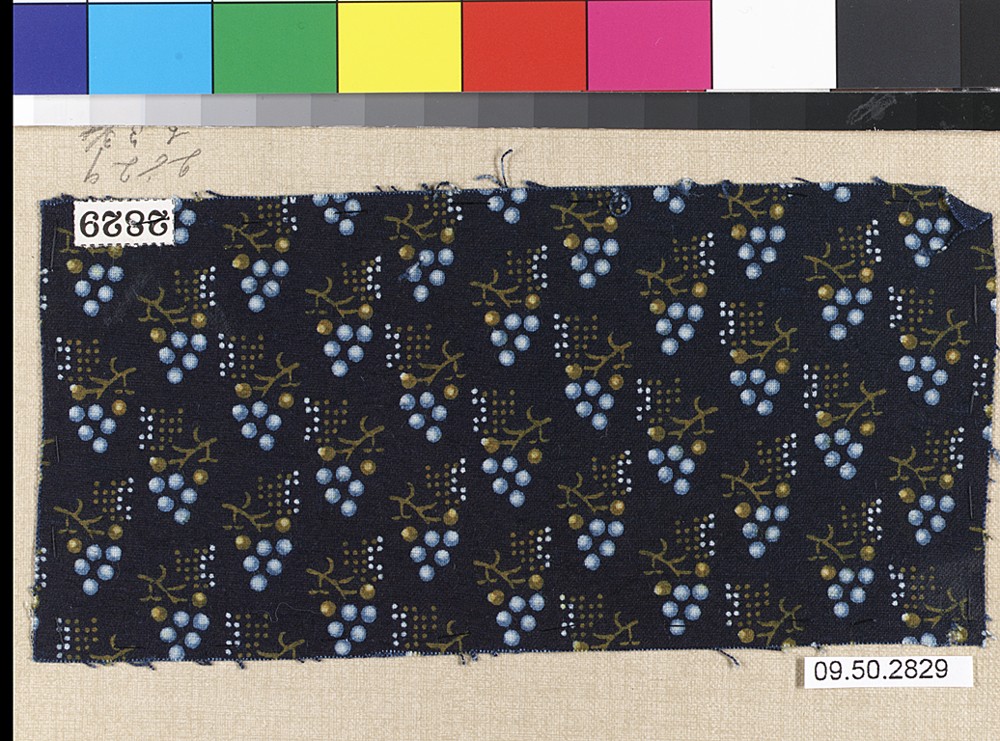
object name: piece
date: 1801-1900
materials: cotton